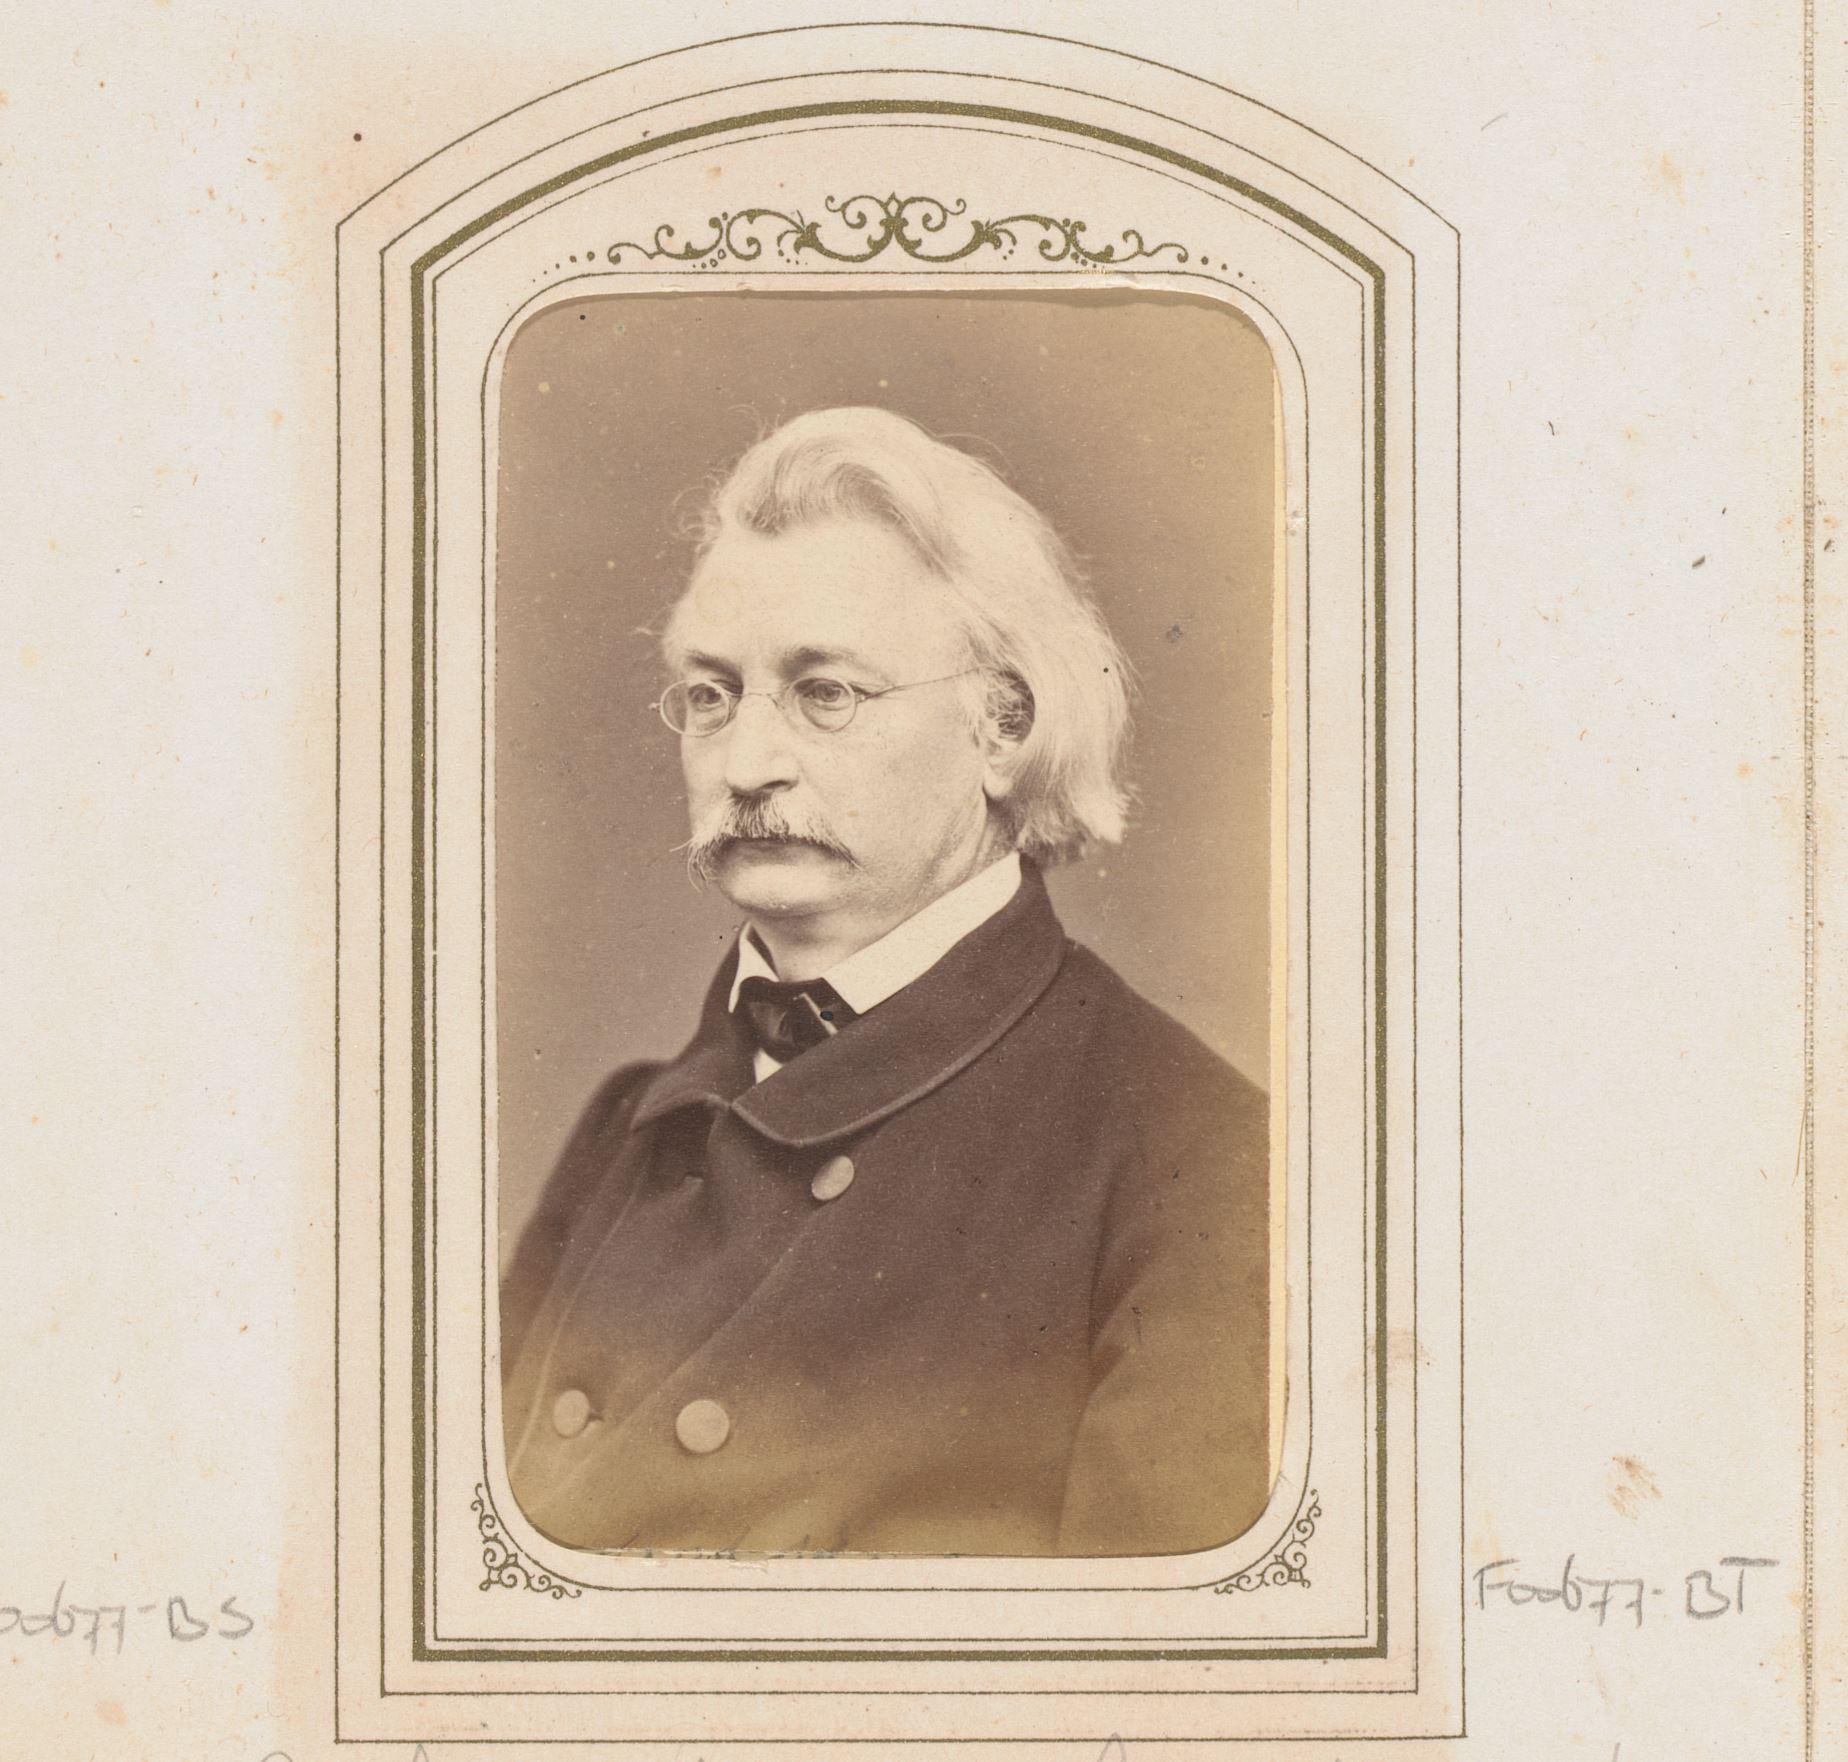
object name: album leaf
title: Portret van Richard Adelbert Lipsius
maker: ernst milster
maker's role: fotograaf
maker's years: 1835-1908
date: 1885-1892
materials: cardboard, photographic support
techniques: albumen print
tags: theologian, historical persons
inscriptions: inscription: ‘Ernst Milster/ Berlin/ 13.Unter den Linden 13.’, name: ‘Lipsius’, annotation: ‘Richard Adelbert Lipsius 1830/92/ D theoloog’